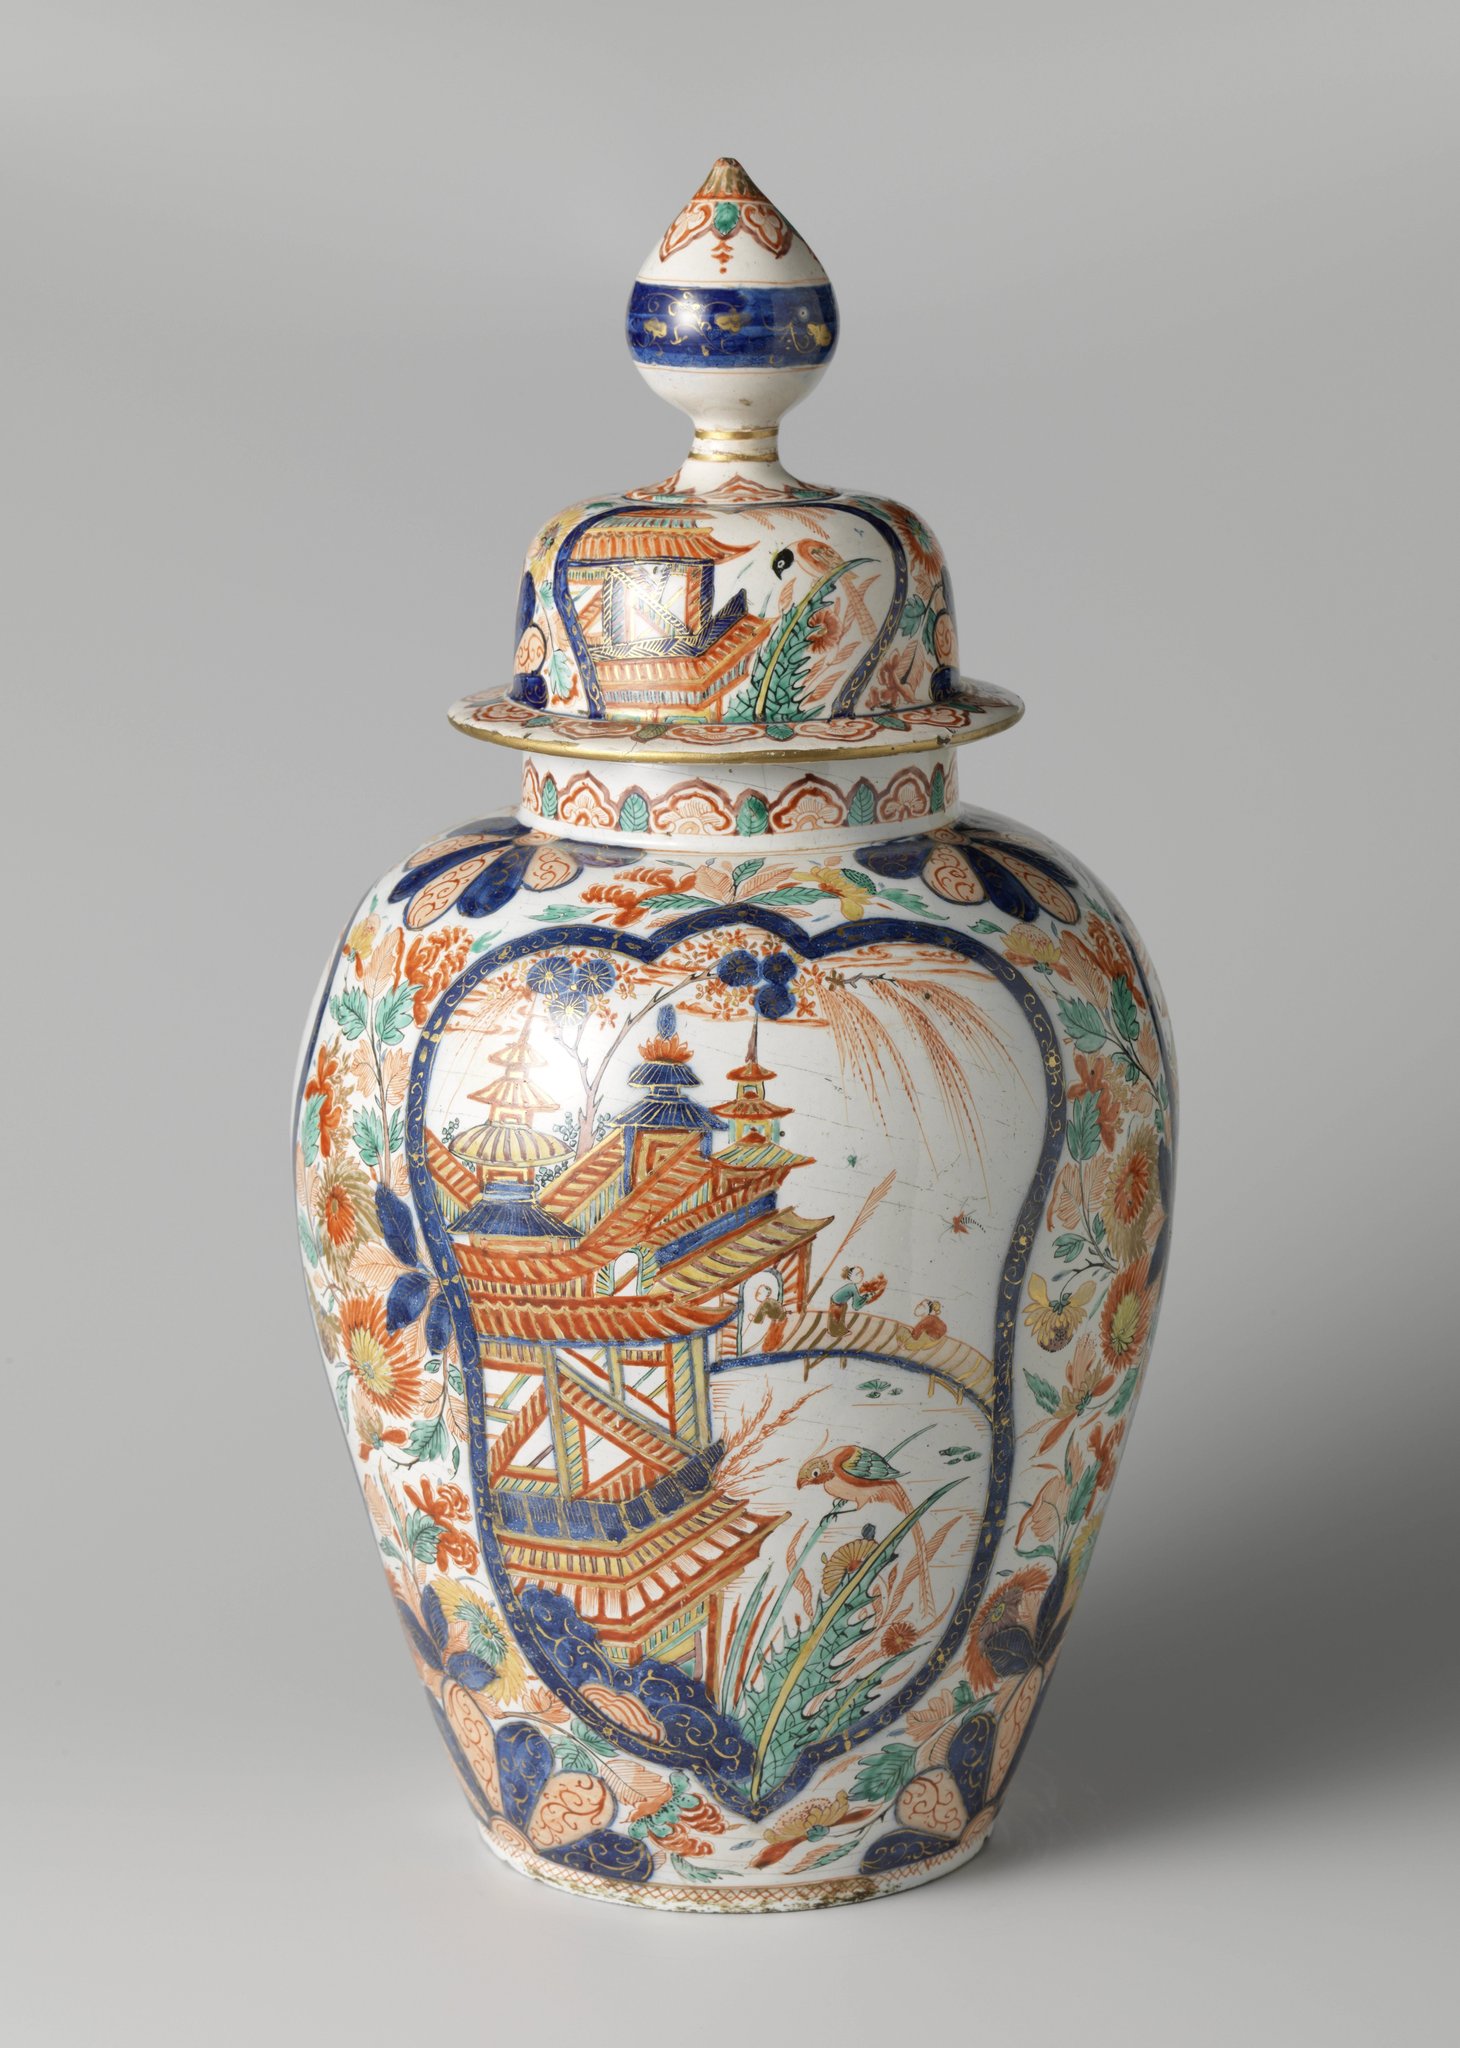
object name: pot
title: Veelkleurig beschilderde pot van faïence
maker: Anonymous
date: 1720-1740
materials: faience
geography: delft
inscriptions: collector's mark: ‘Collection J.F. Loudon’, mark: ‘513’, mark: ‘64’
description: Pot van faïence. Veelkleurig beschilderd met chinese huizen en bloemendecoratie.